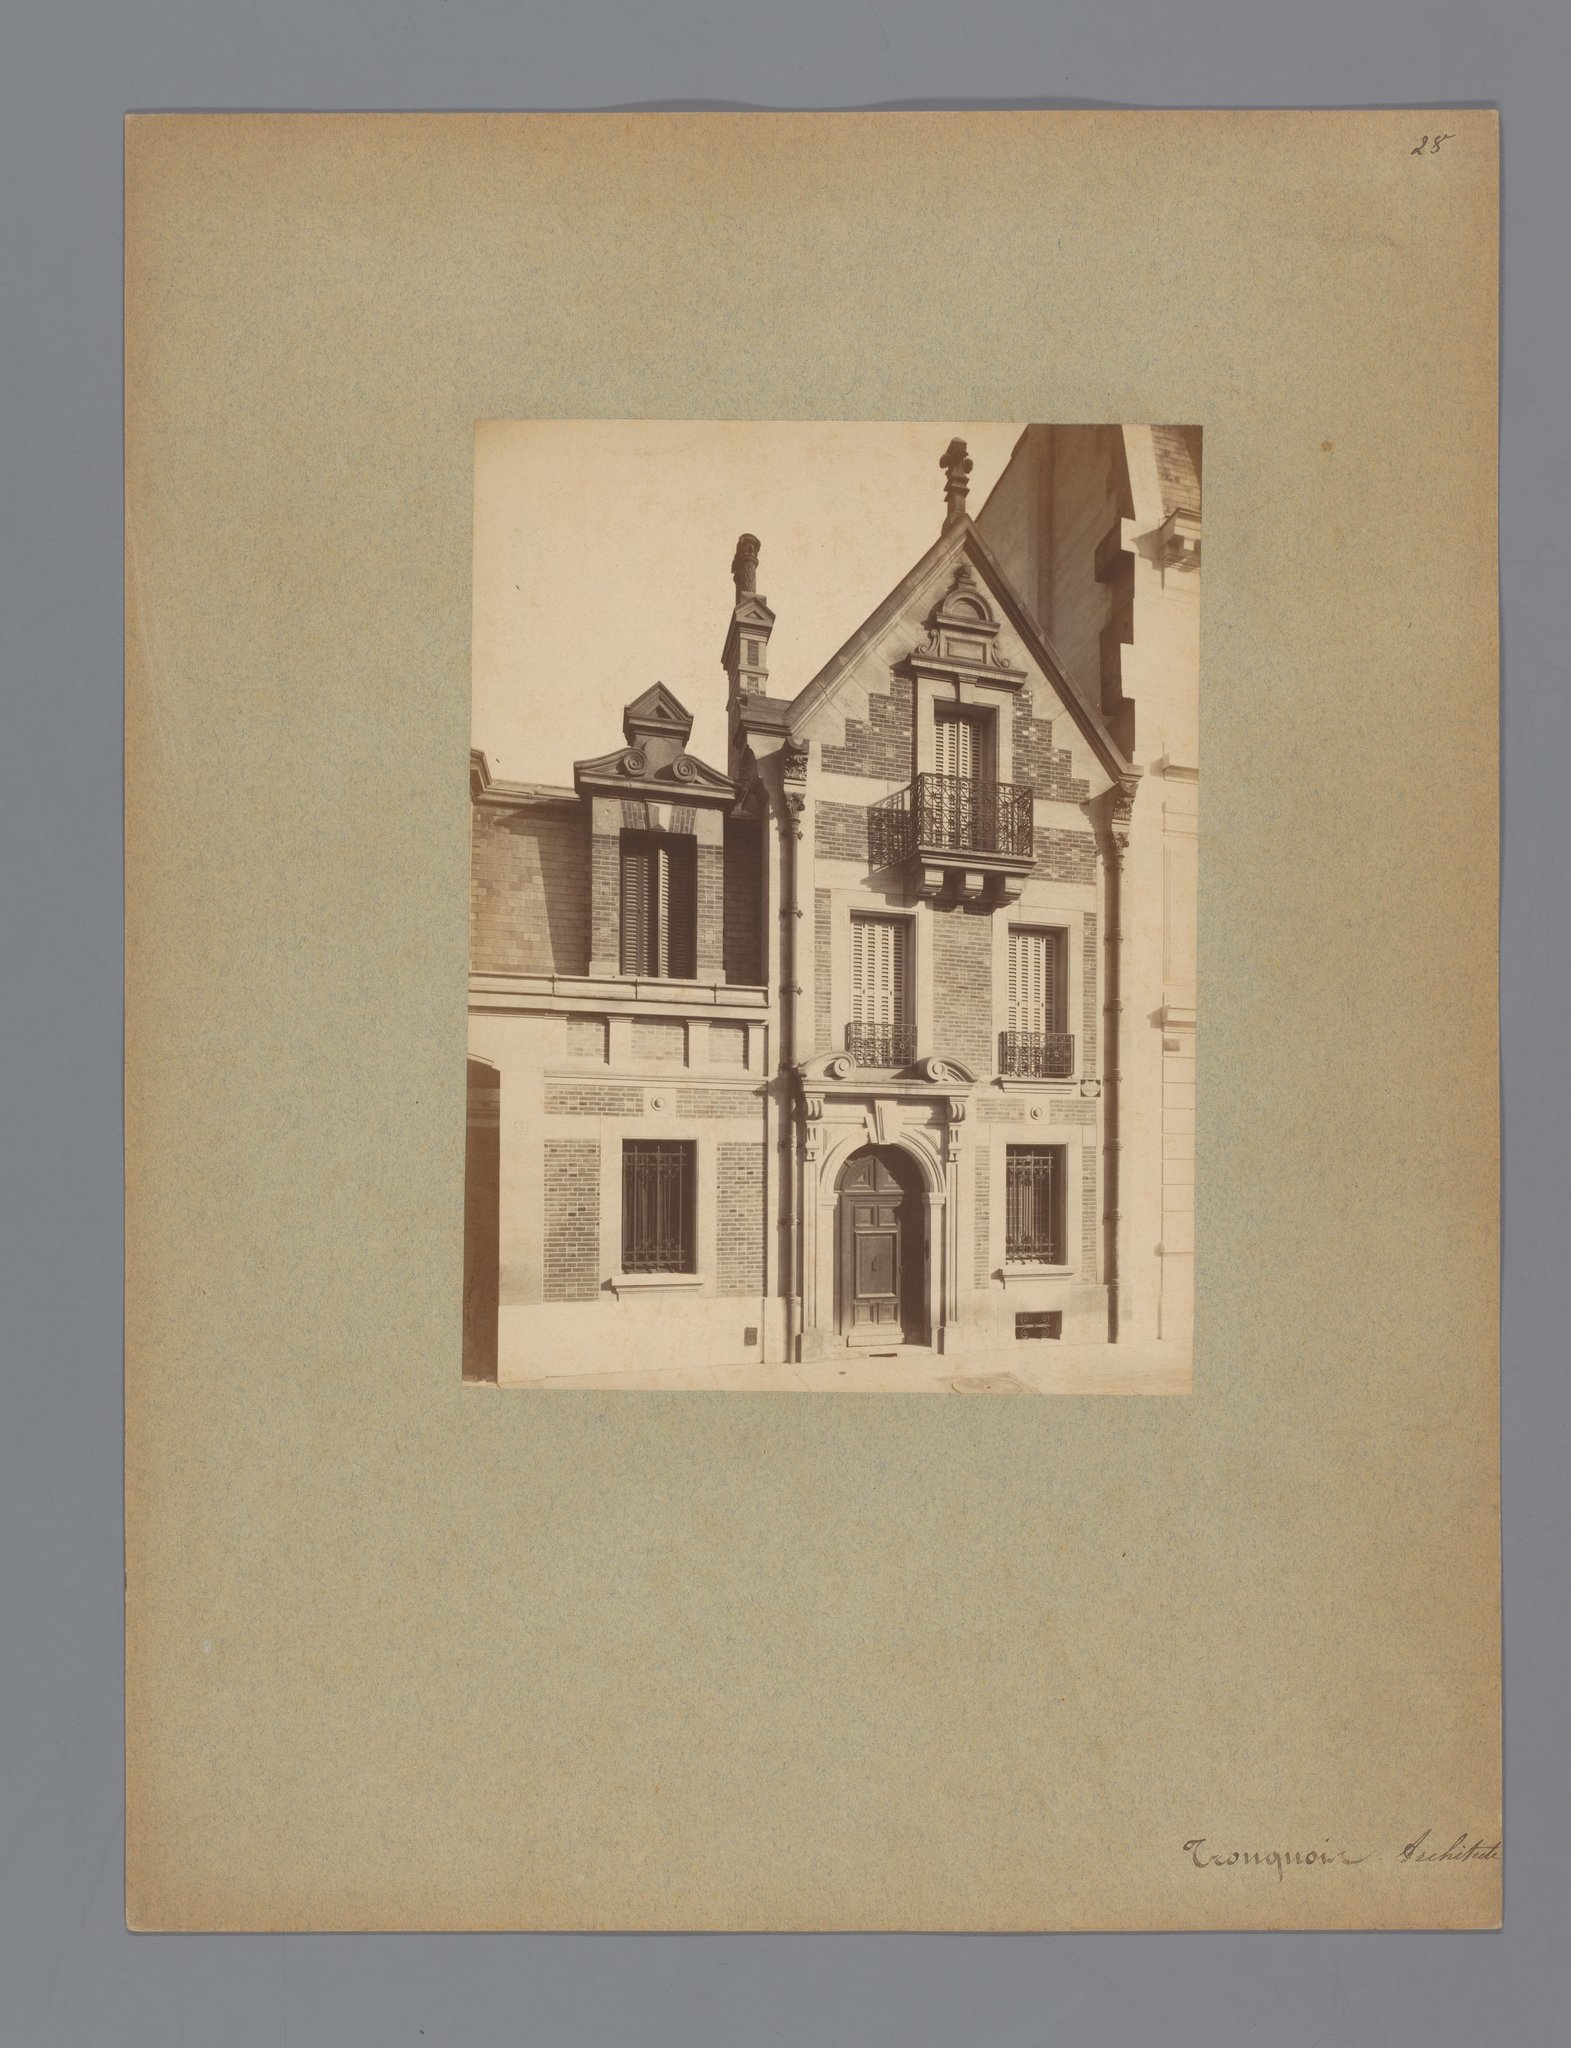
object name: photograph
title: Façade van een woonhuis in Parijs, ontworpen door Auguste Tronquois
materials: photographic support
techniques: albumen print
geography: paris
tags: urban housing, façade (of house or building), paris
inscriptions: number: ‘28’, name: ‘Tronquois Architecte’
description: Deze foto maakt deel uit van een omslag met 35 foto's en een titelblad.